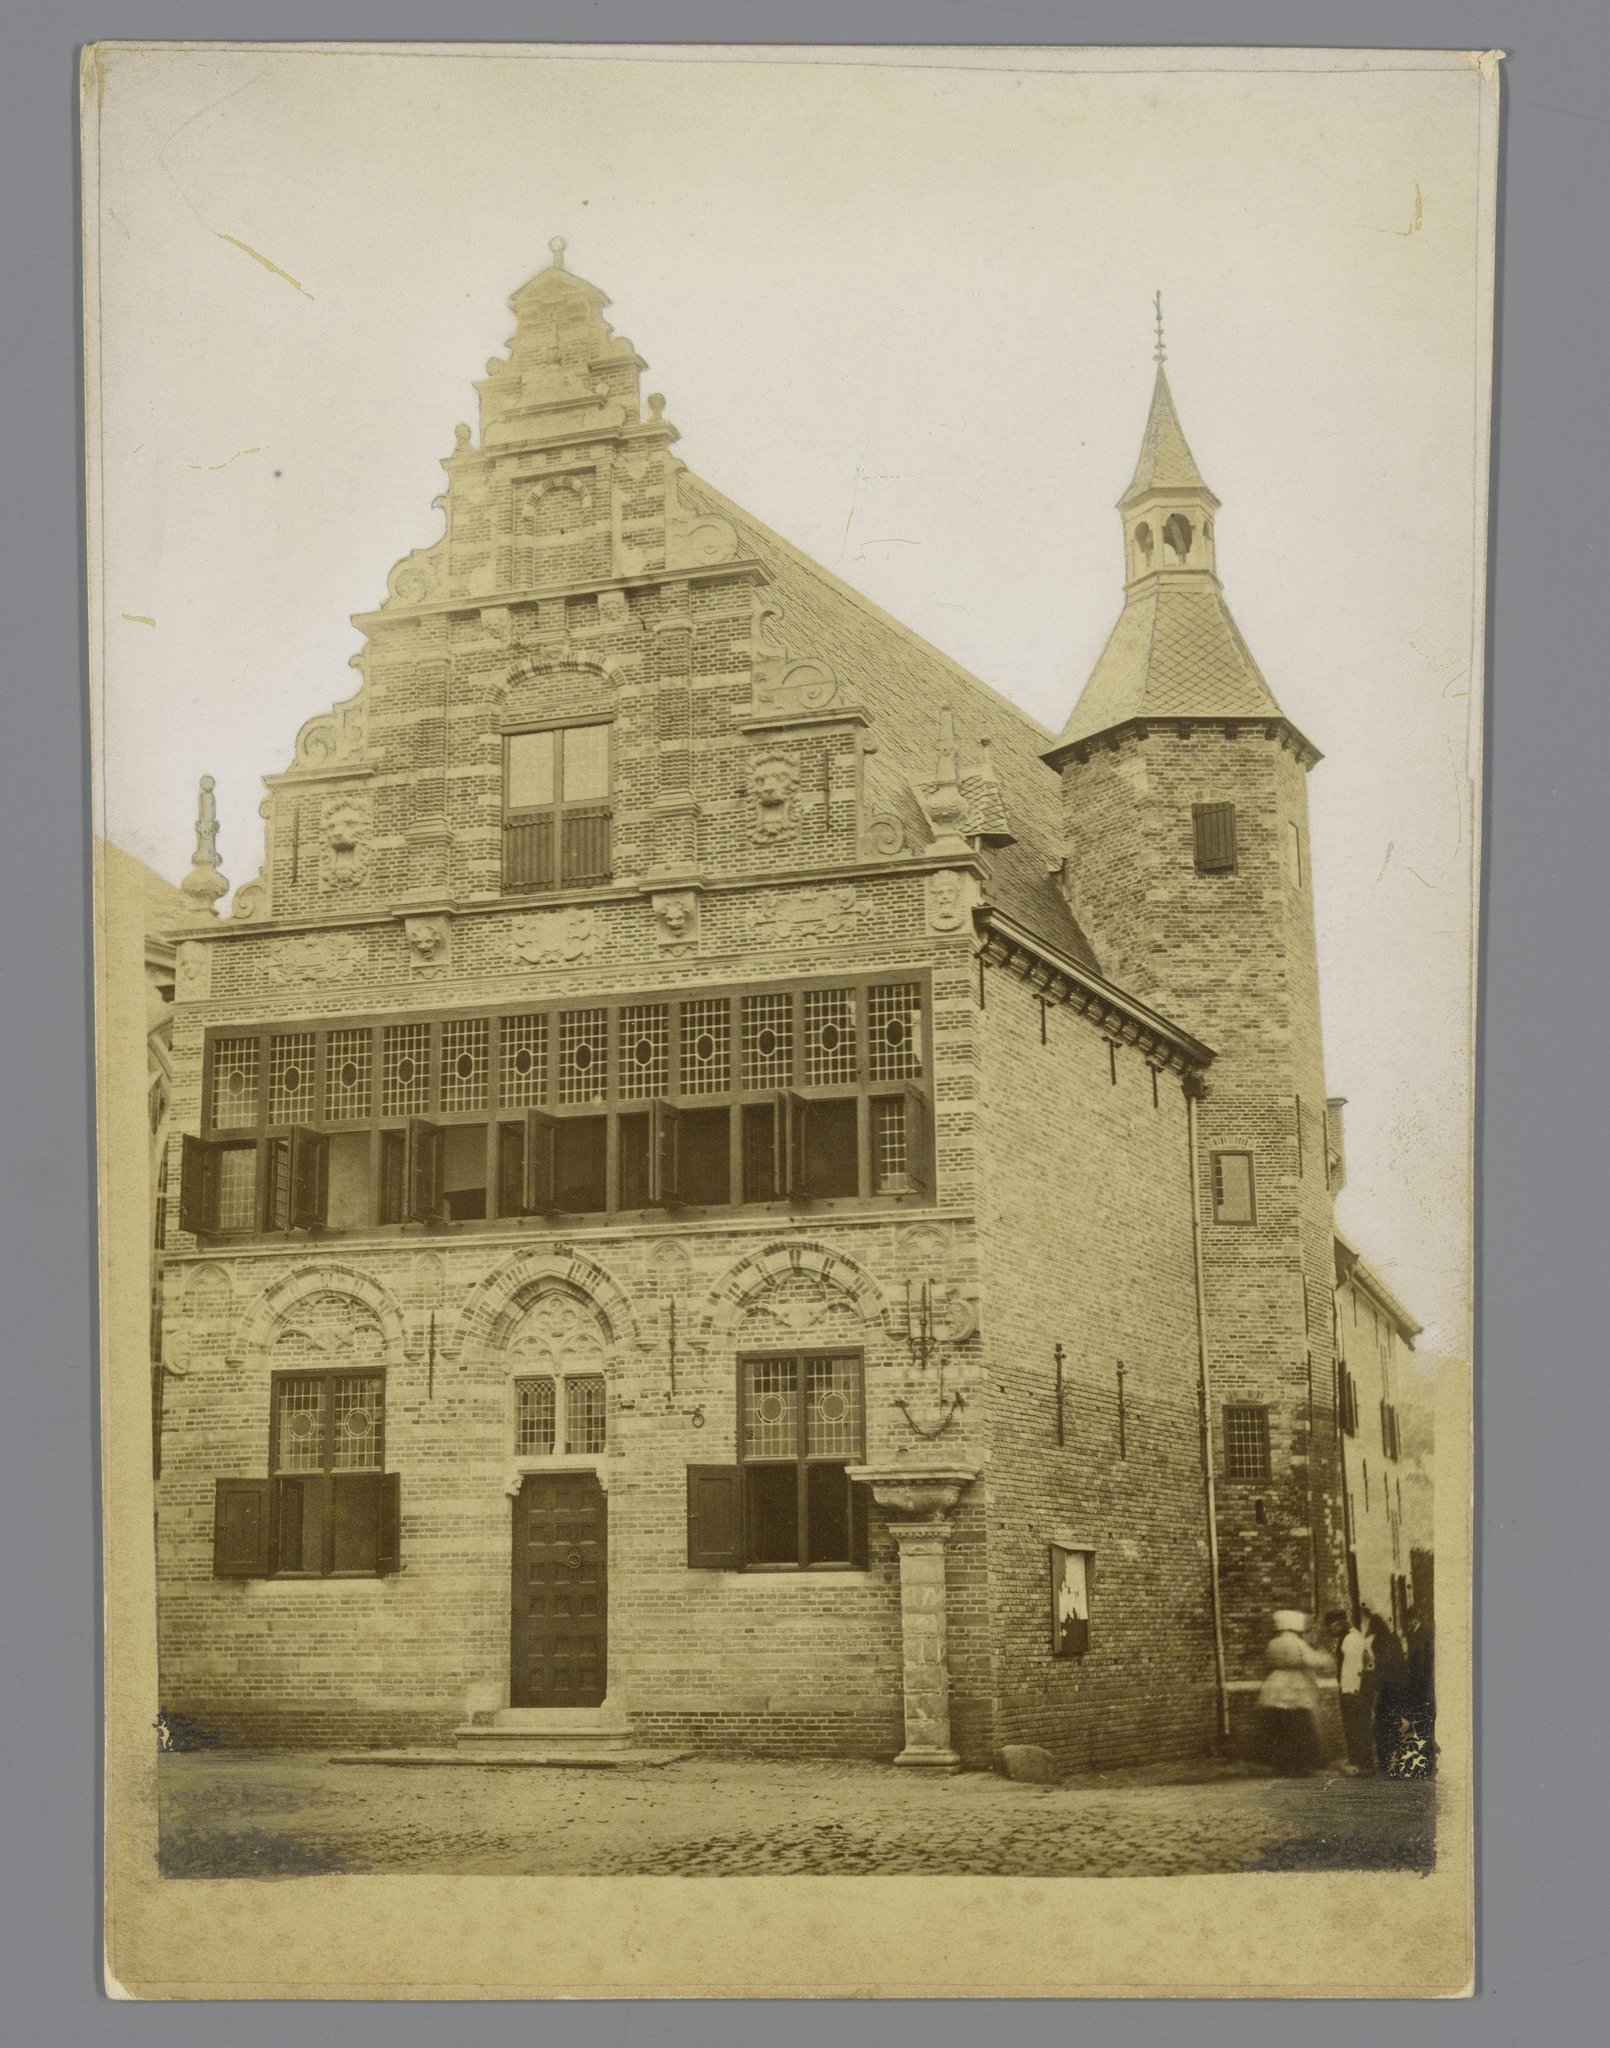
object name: photograph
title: Gezicht op de Waag te Woerden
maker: Anonymous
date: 1870-1900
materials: cardboard, photographic support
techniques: albumen print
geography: woerden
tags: weigh-house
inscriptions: annotation: ‘Woerden/ RPK’